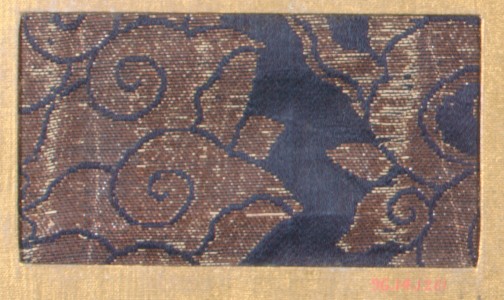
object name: piece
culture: chinese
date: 1701-1900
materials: silk